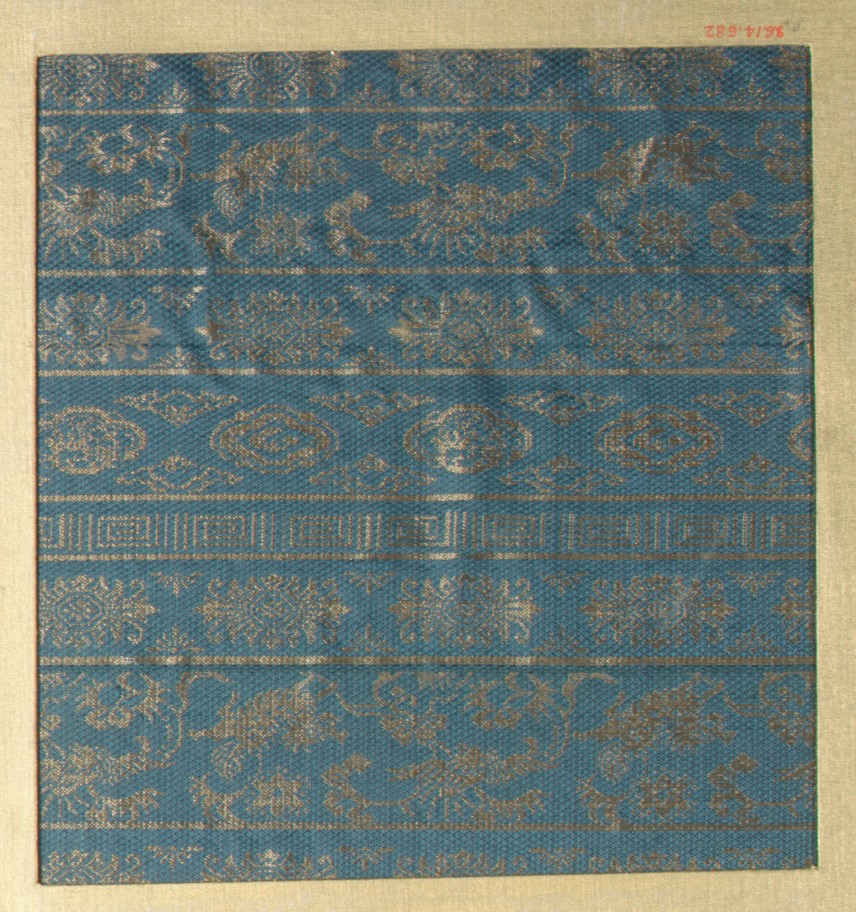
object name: piece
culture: japanese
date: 1701-1900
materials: silk